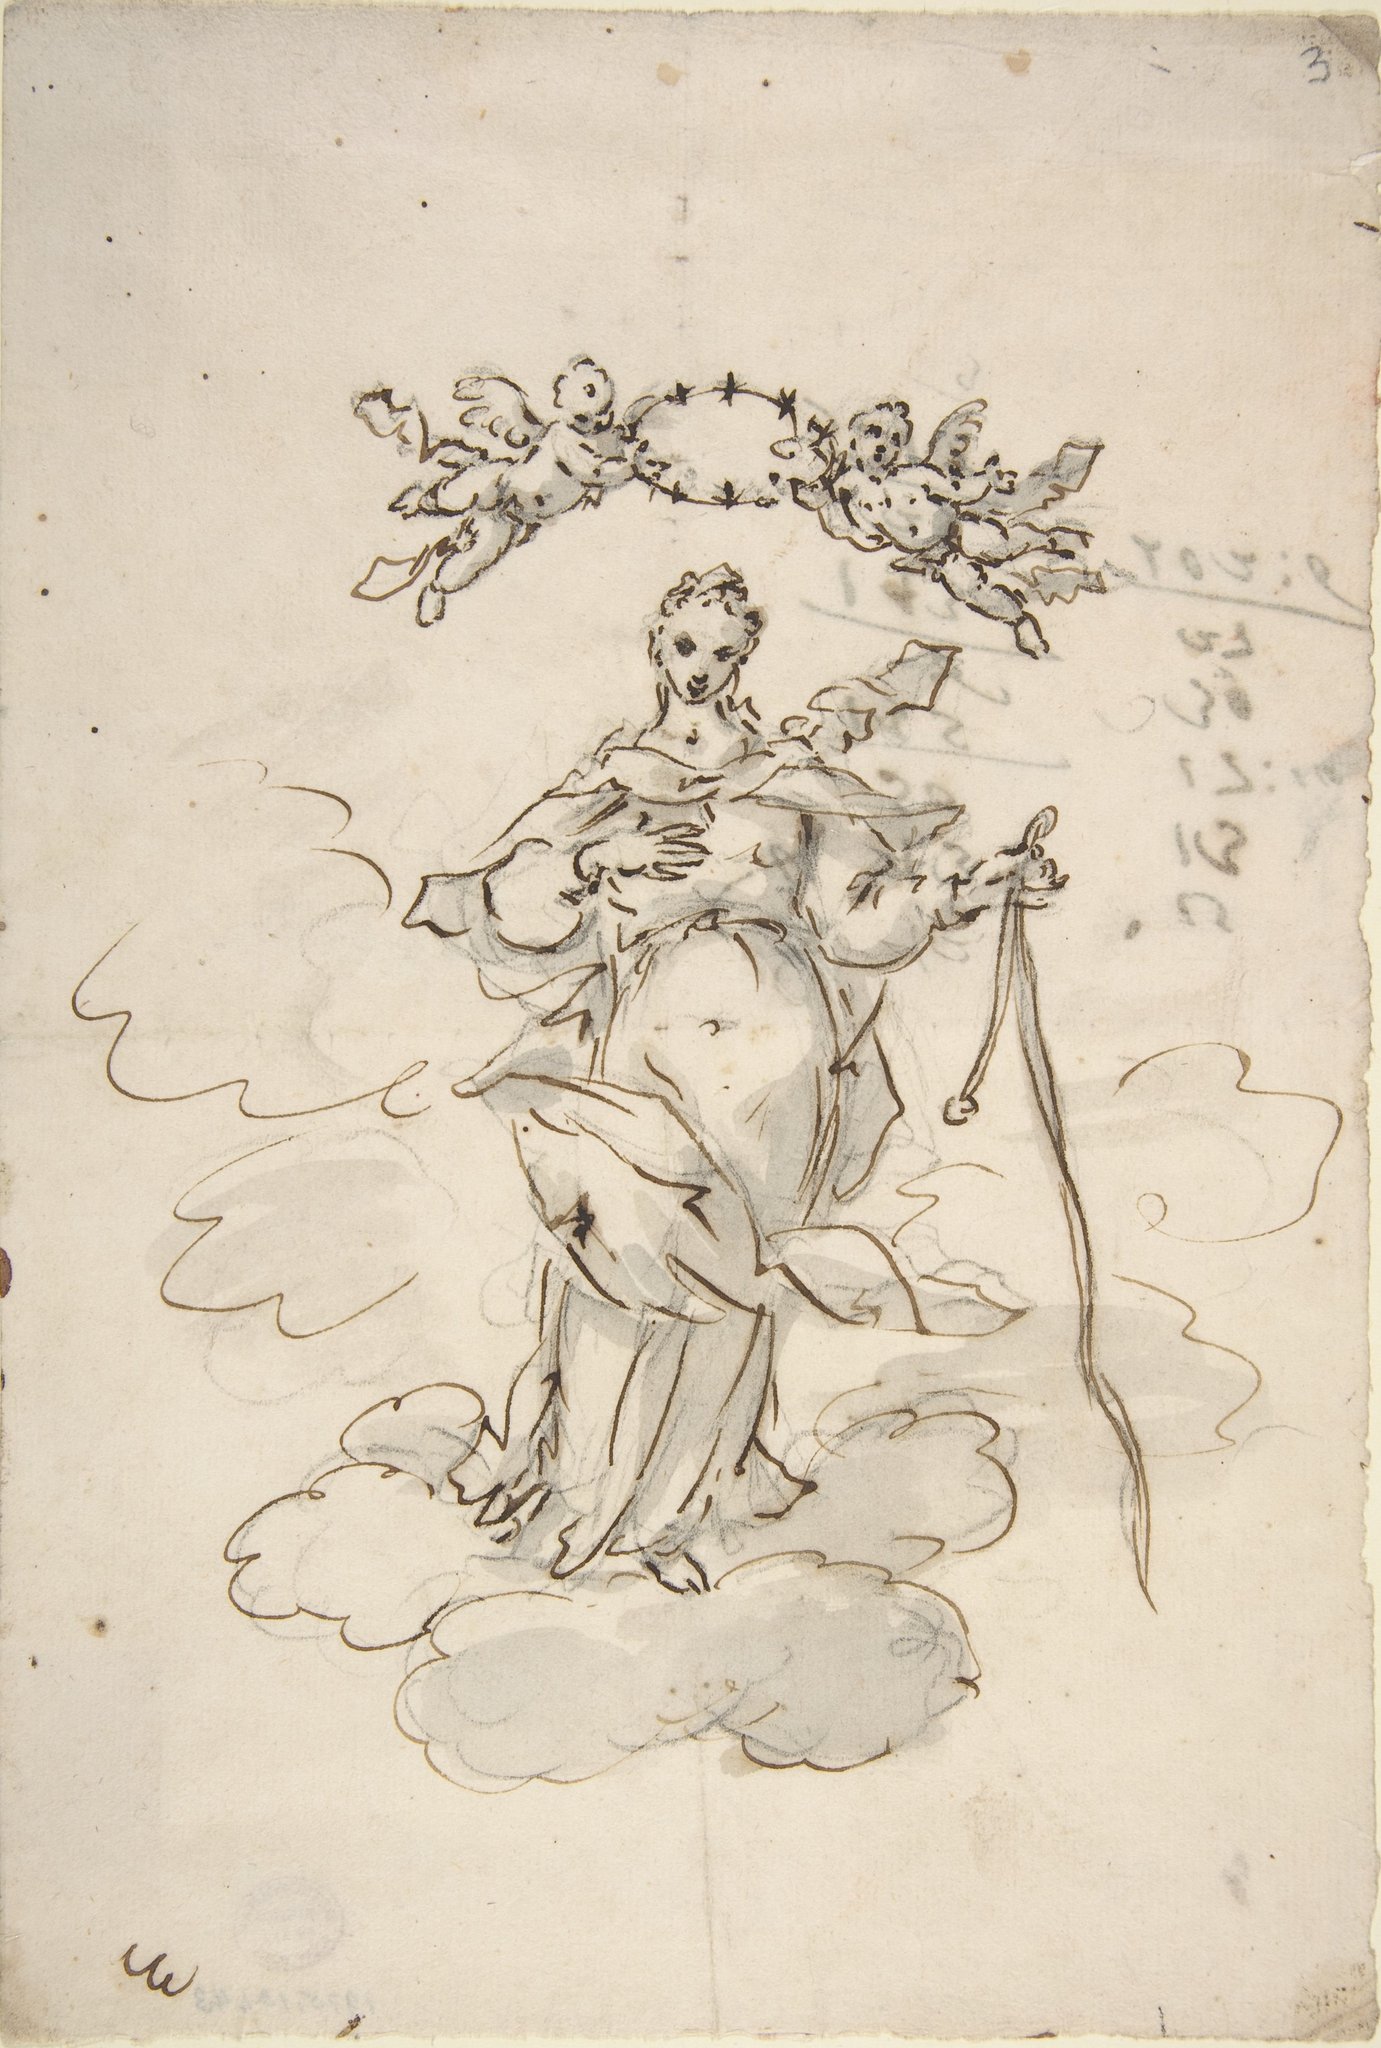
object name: drawing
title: Virgin Standing on Clouds Holding a Scapular in Her Left Hand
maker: giovanni antonio pellegrini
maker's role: artist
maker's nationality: italian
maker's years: 1675-1741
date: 1675-1741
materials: chalk, ink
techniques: brush, pen, wash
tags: virgin mary